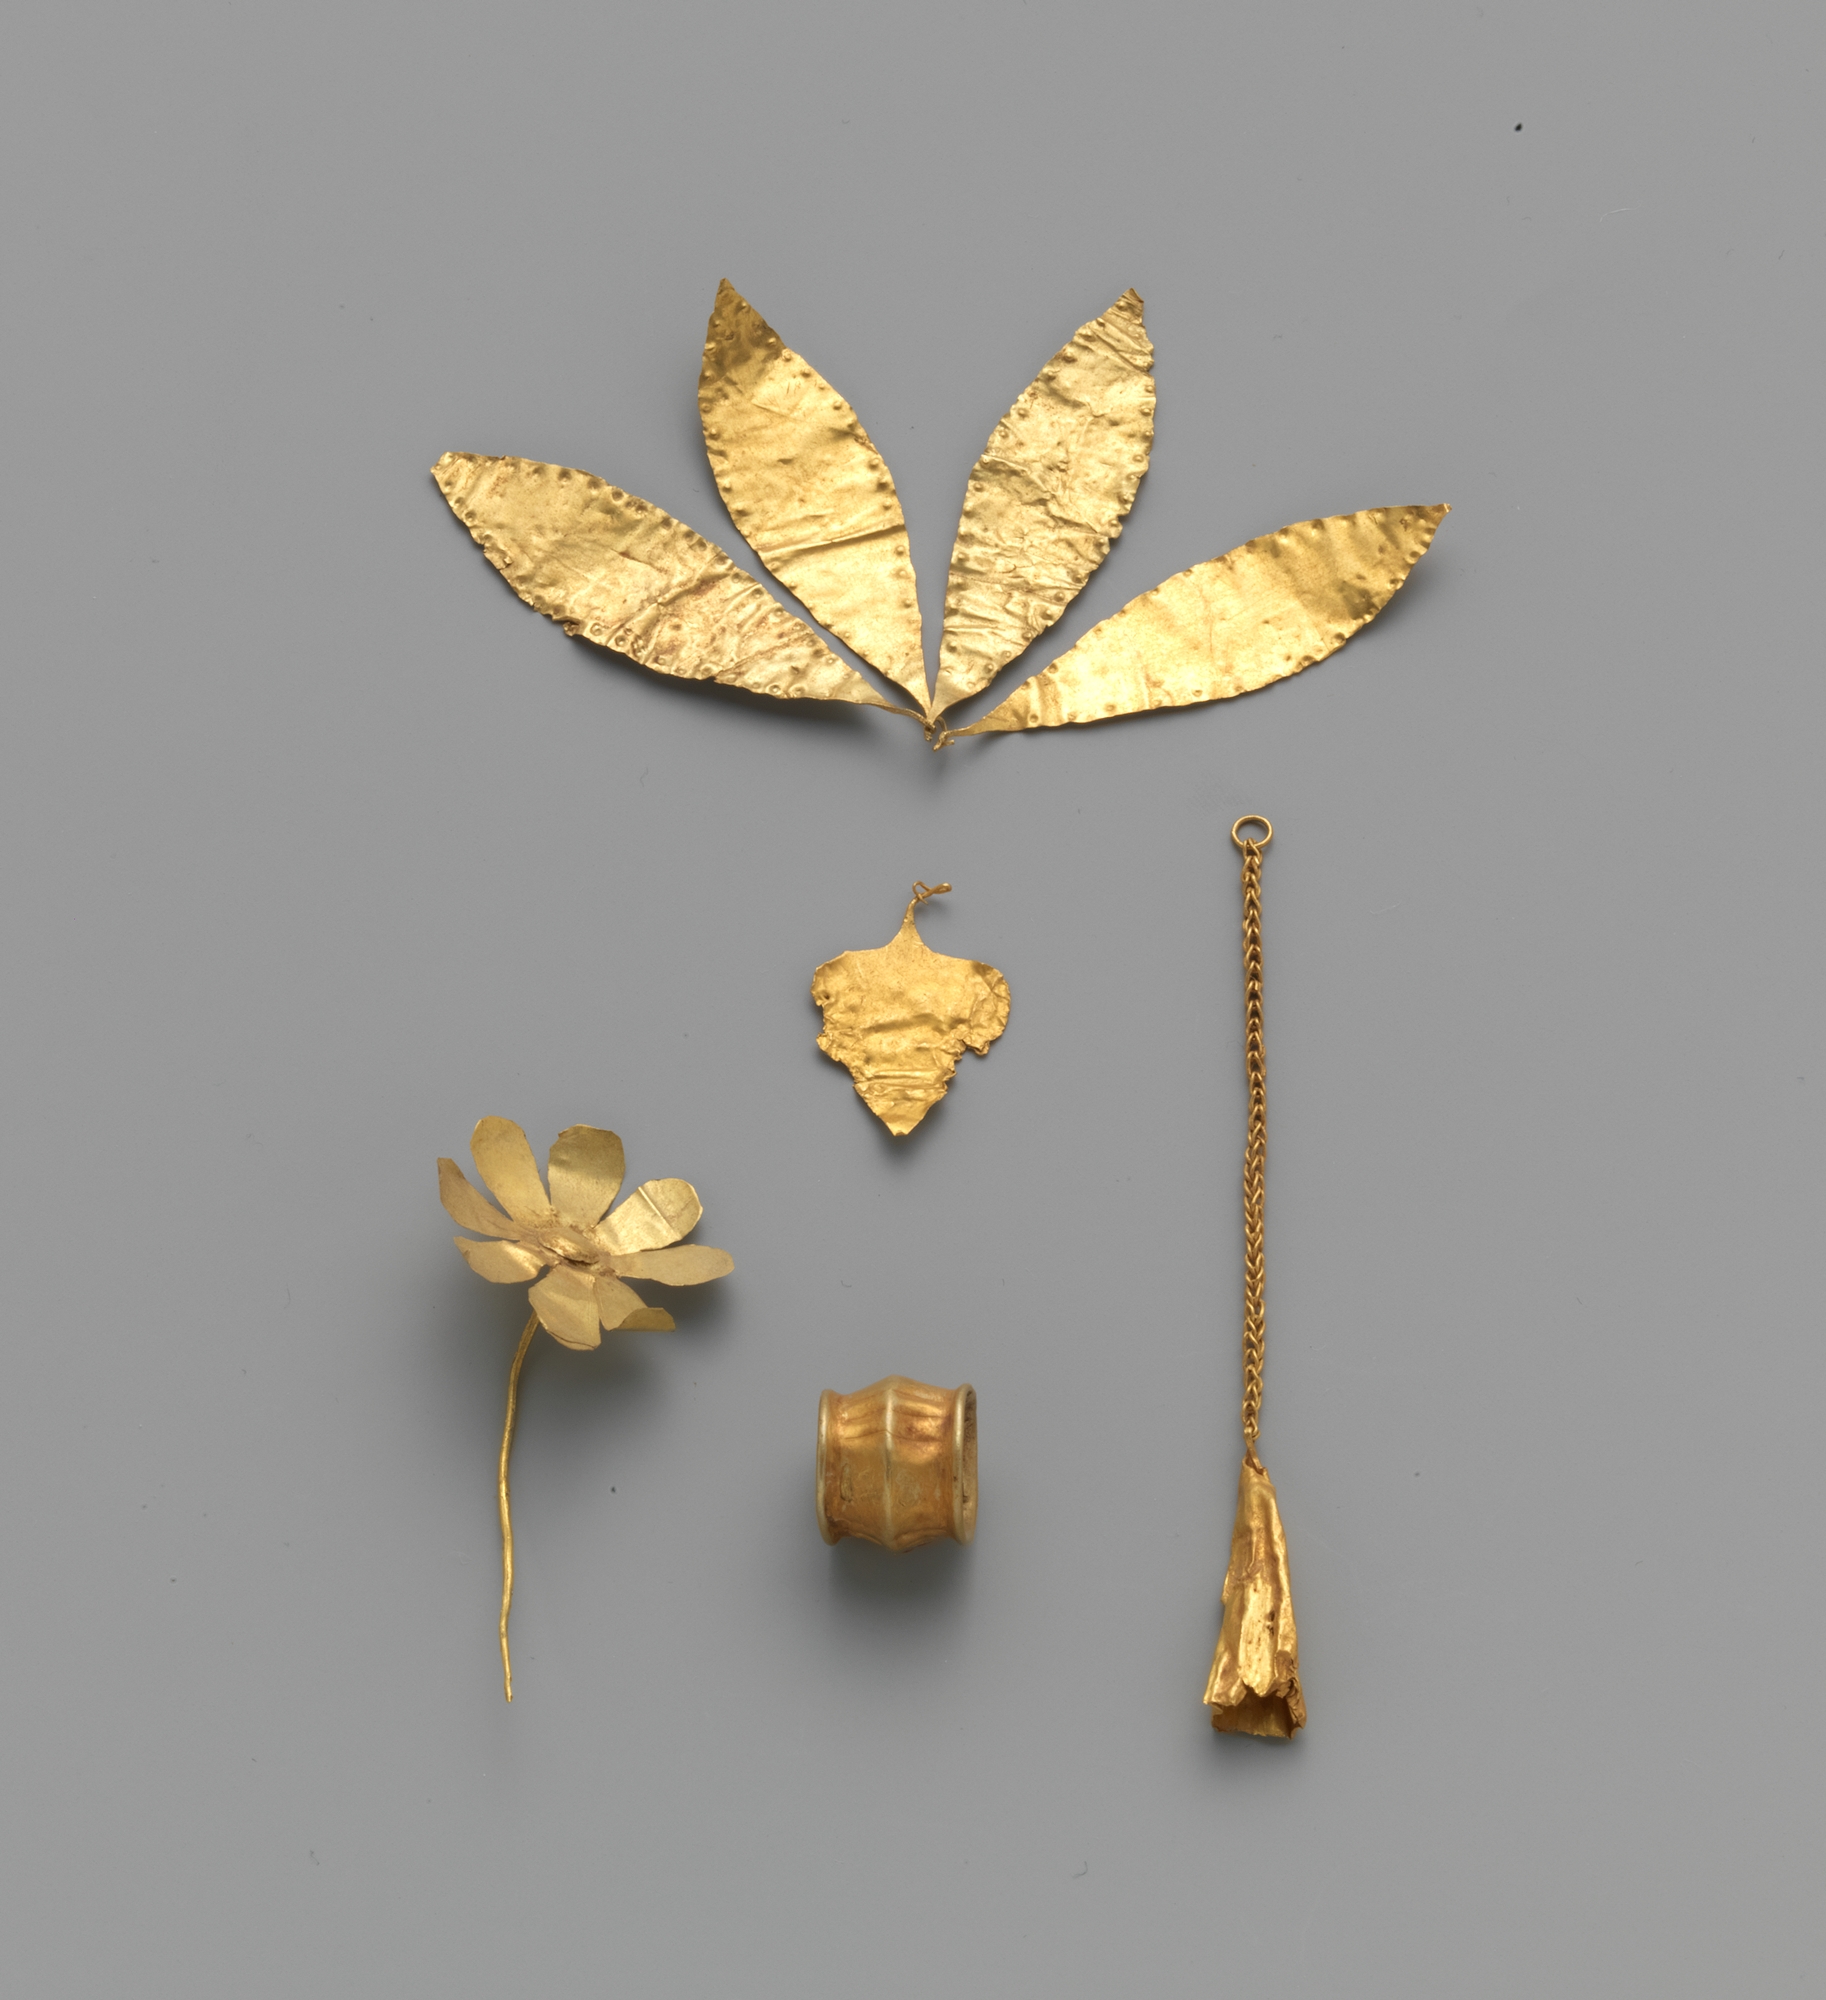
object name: ornament, flower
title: Gold flower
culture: minoan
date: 2300-2100 BCE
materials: gold